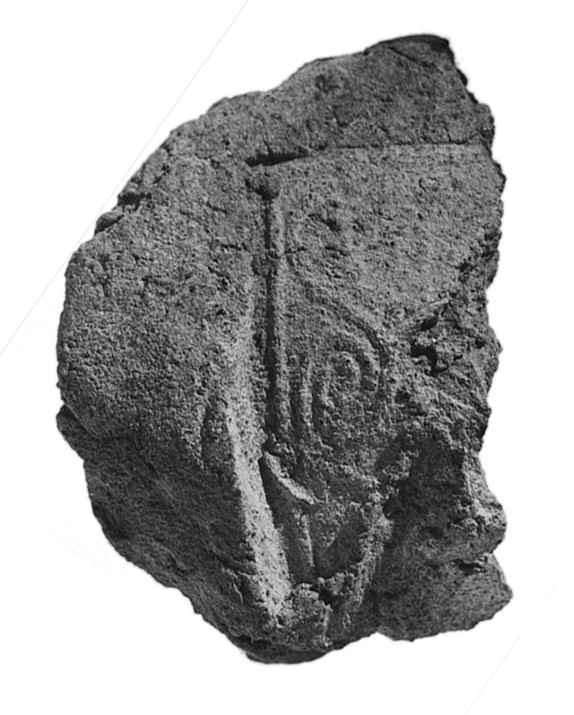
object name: sealing fragment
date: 2030-1640 BCE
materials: clay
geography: egypt